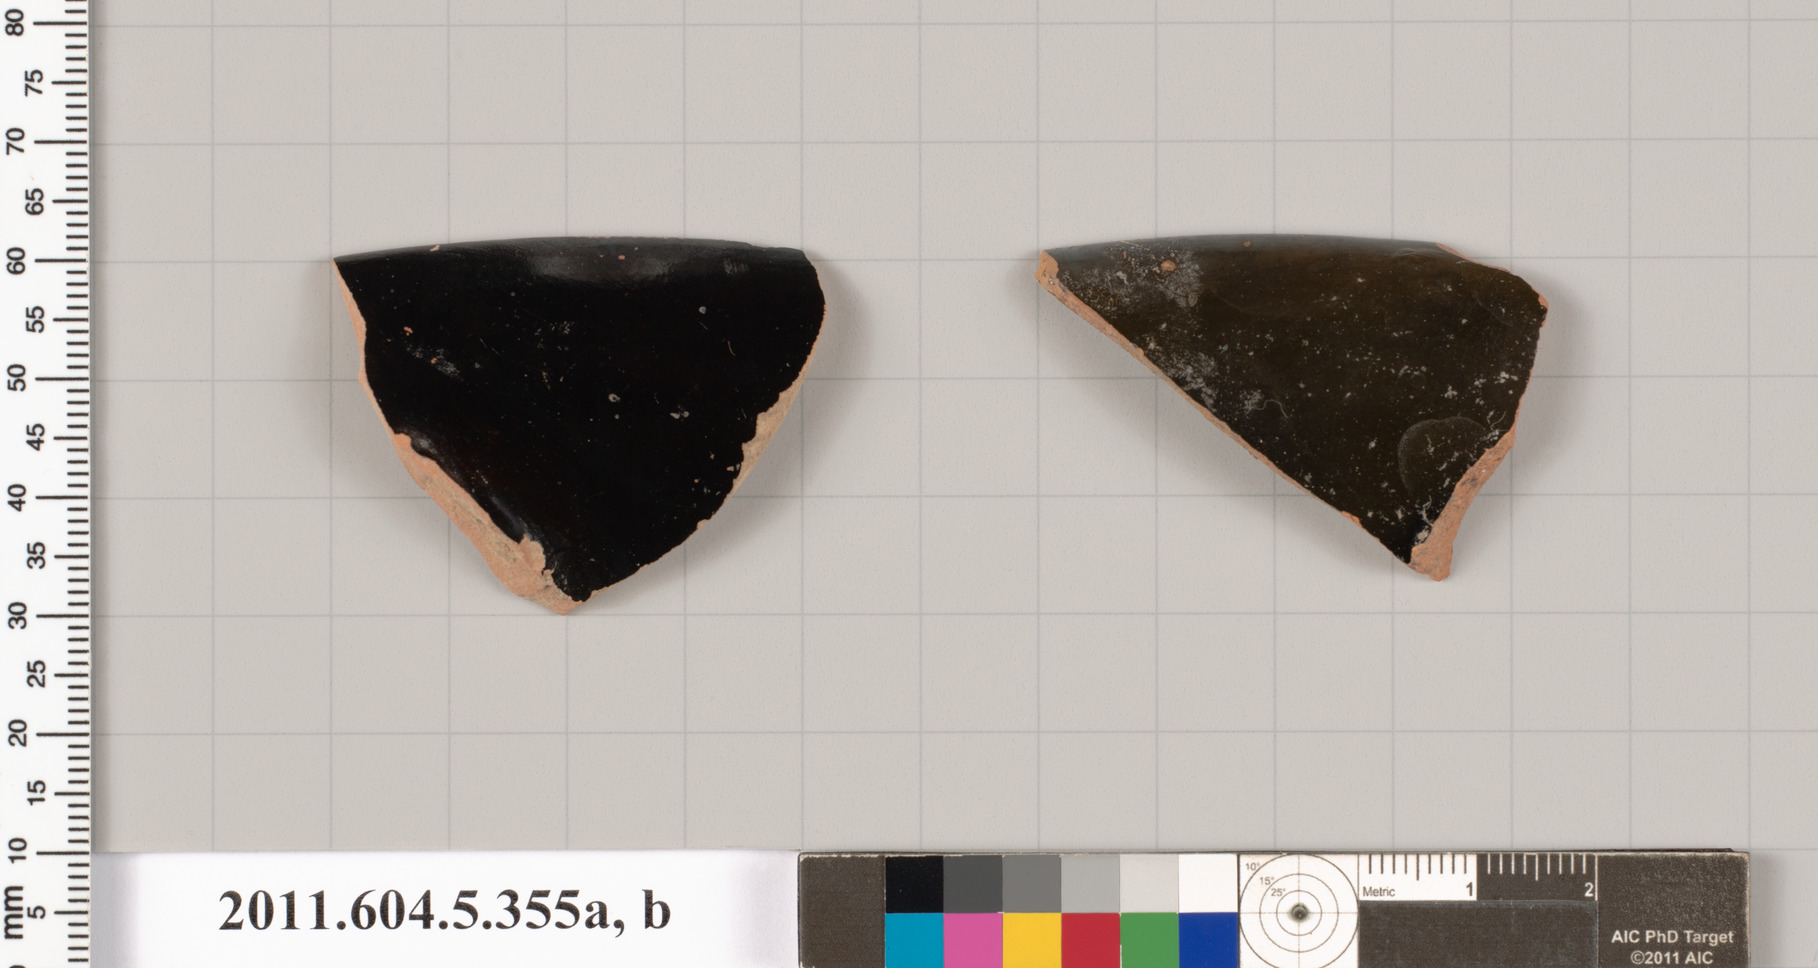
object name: kylix fragment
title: Terracotta rim fragments of kylikes (drinking cups)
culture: greek, attic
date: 600-401 BCE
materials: terracotta